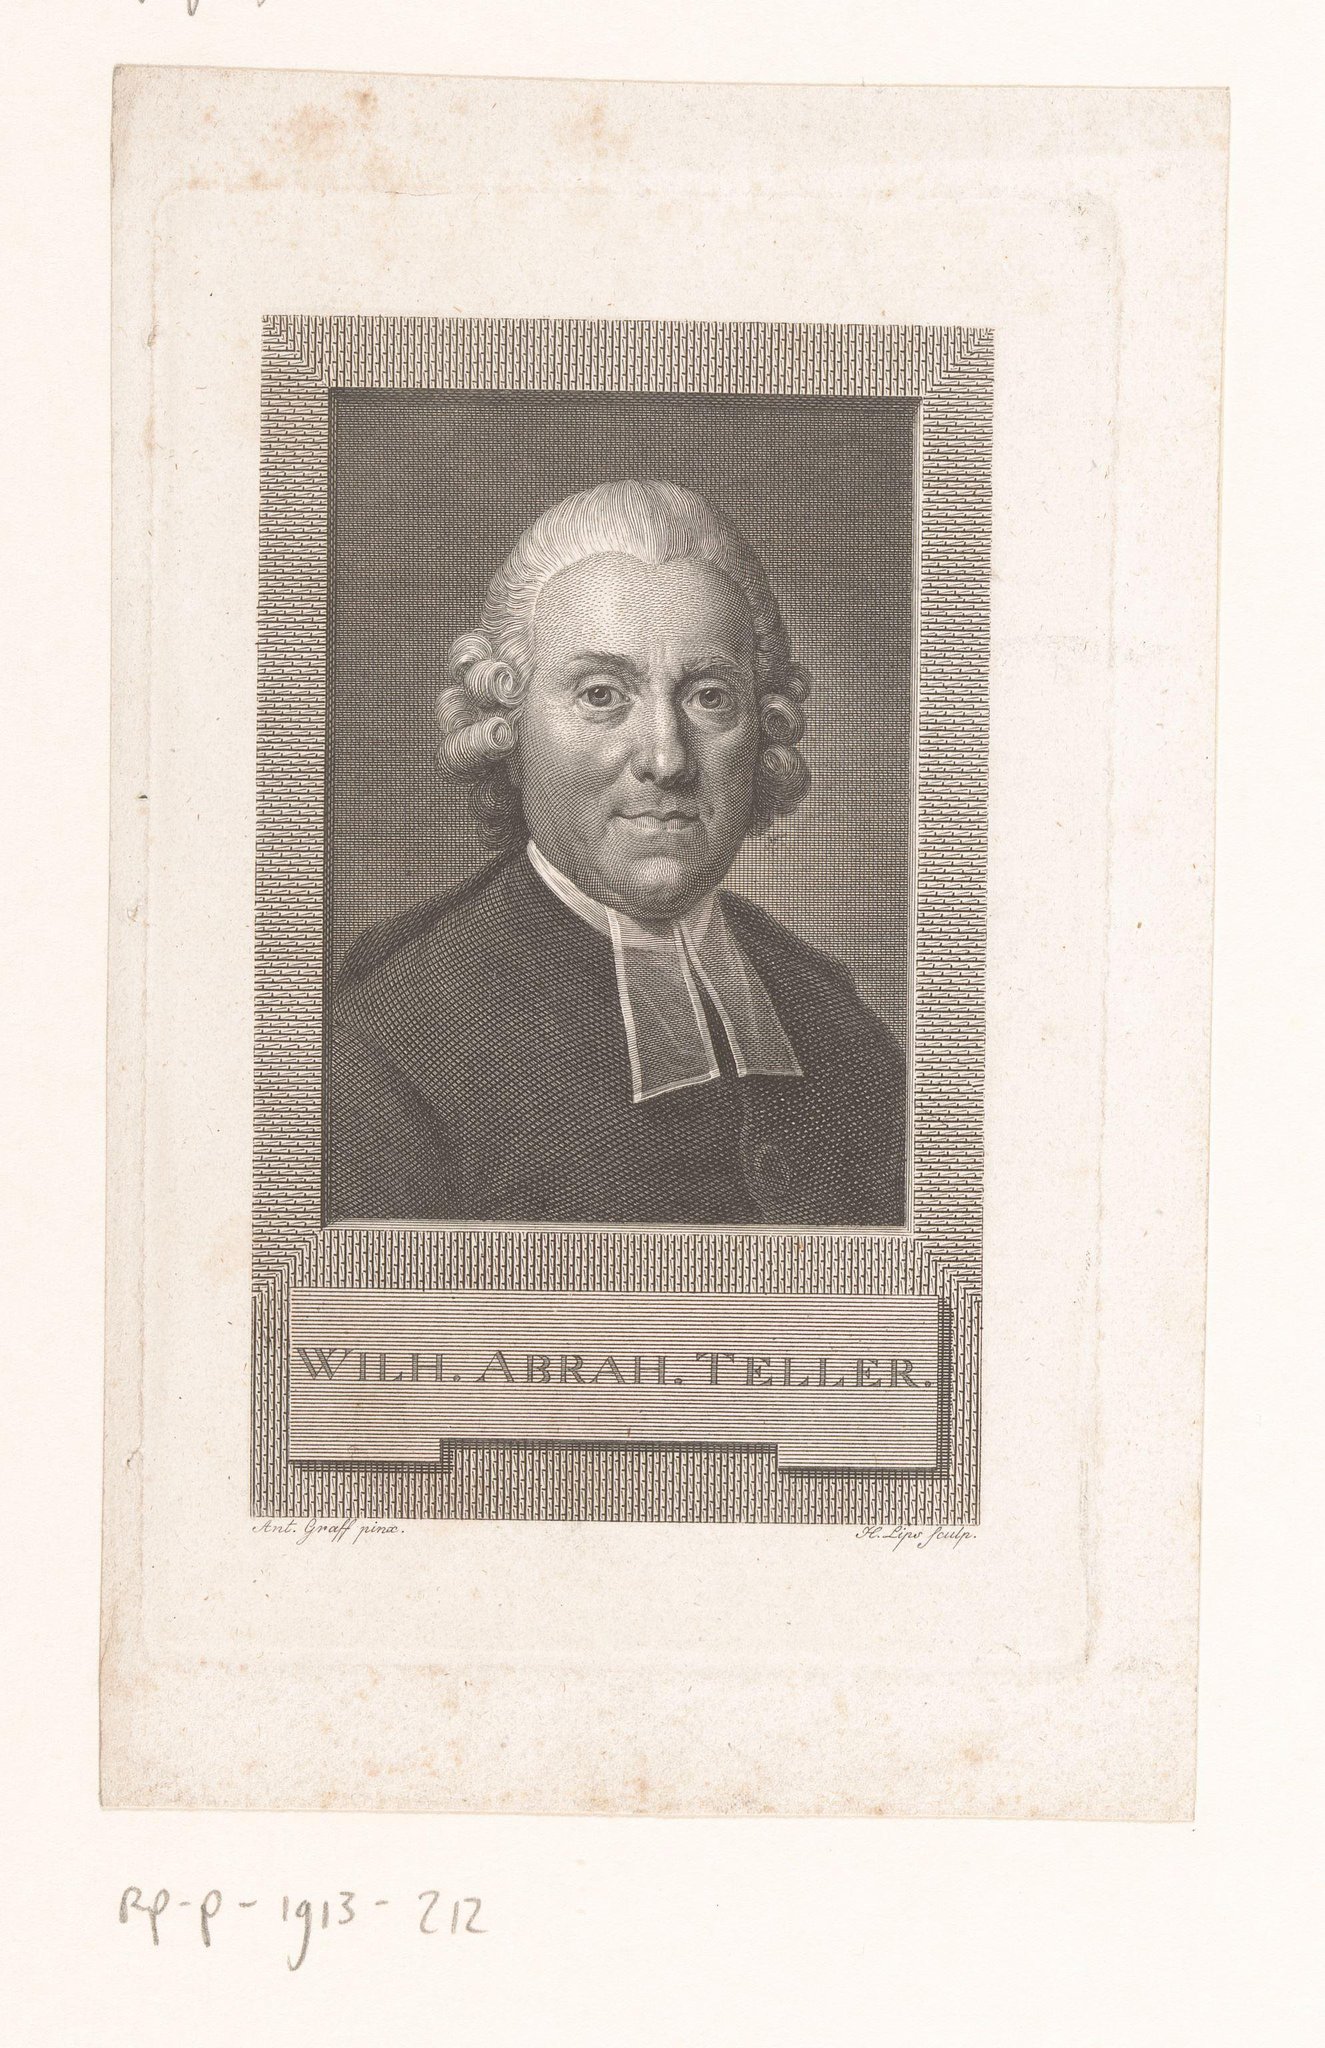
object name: print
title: Portret van Wilhelm Abraham Teller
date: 1768-1817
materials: paper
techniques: engraving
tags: berlin, theologian, historical persons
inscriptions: collector's mark: Lugt 2228